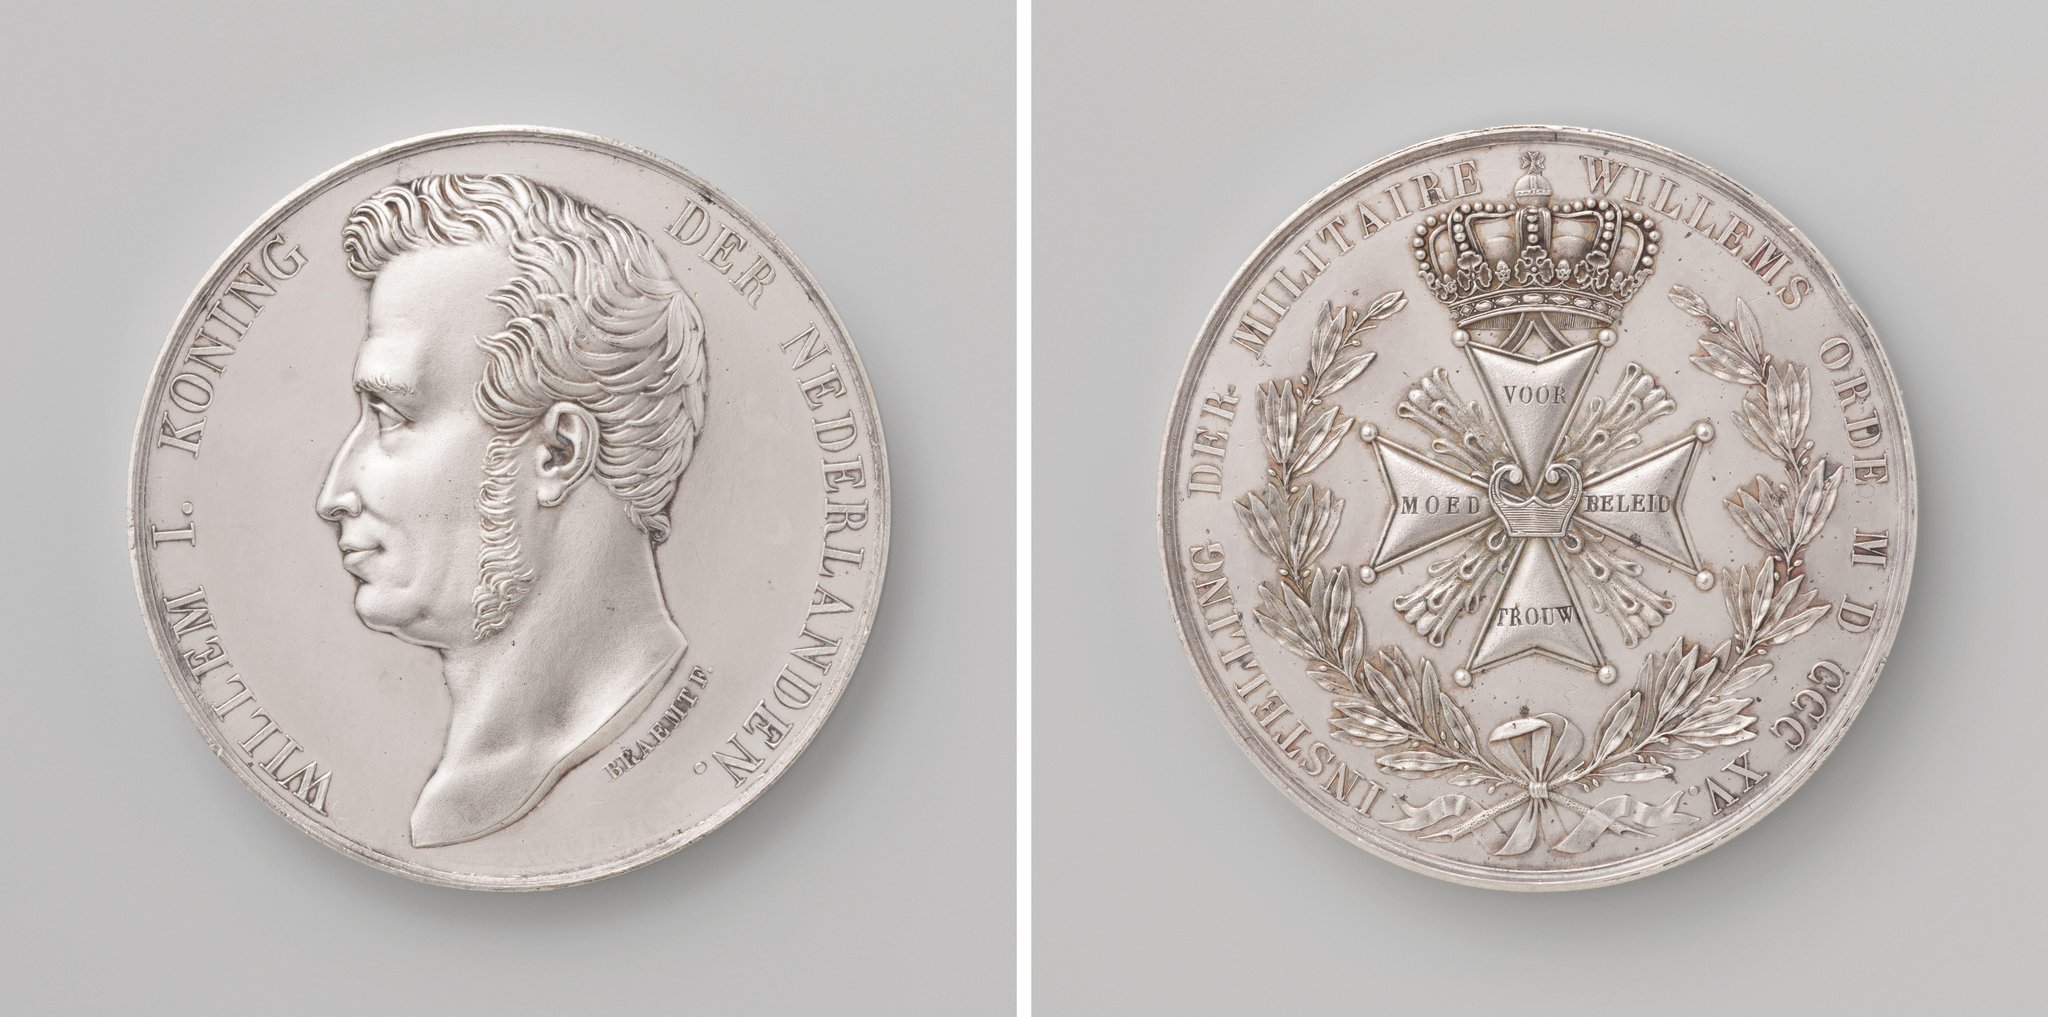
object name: history medal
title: Instelling der militaire Willemsorde, ter ere van Willem I Frederik, koning der Nederlanden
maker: joseph pierre braemt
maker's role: print maker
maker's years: 1796-1864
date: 1815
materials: silver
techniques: striking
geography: brussels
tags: the hague, berlin, william i of the netherlands, netherlands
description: Zilveren penning. Voorzijde: borststuk man binnen omschrift. Keerzijde: Willemsorde: gekroond kruis bestaaande uit vier armen, die elk twee met parel bekroonde punten hebben en opschrift dragen; in hart van vier armen een vuurslag op Bourgondisch kruis binnen olijfkrans en omschrift